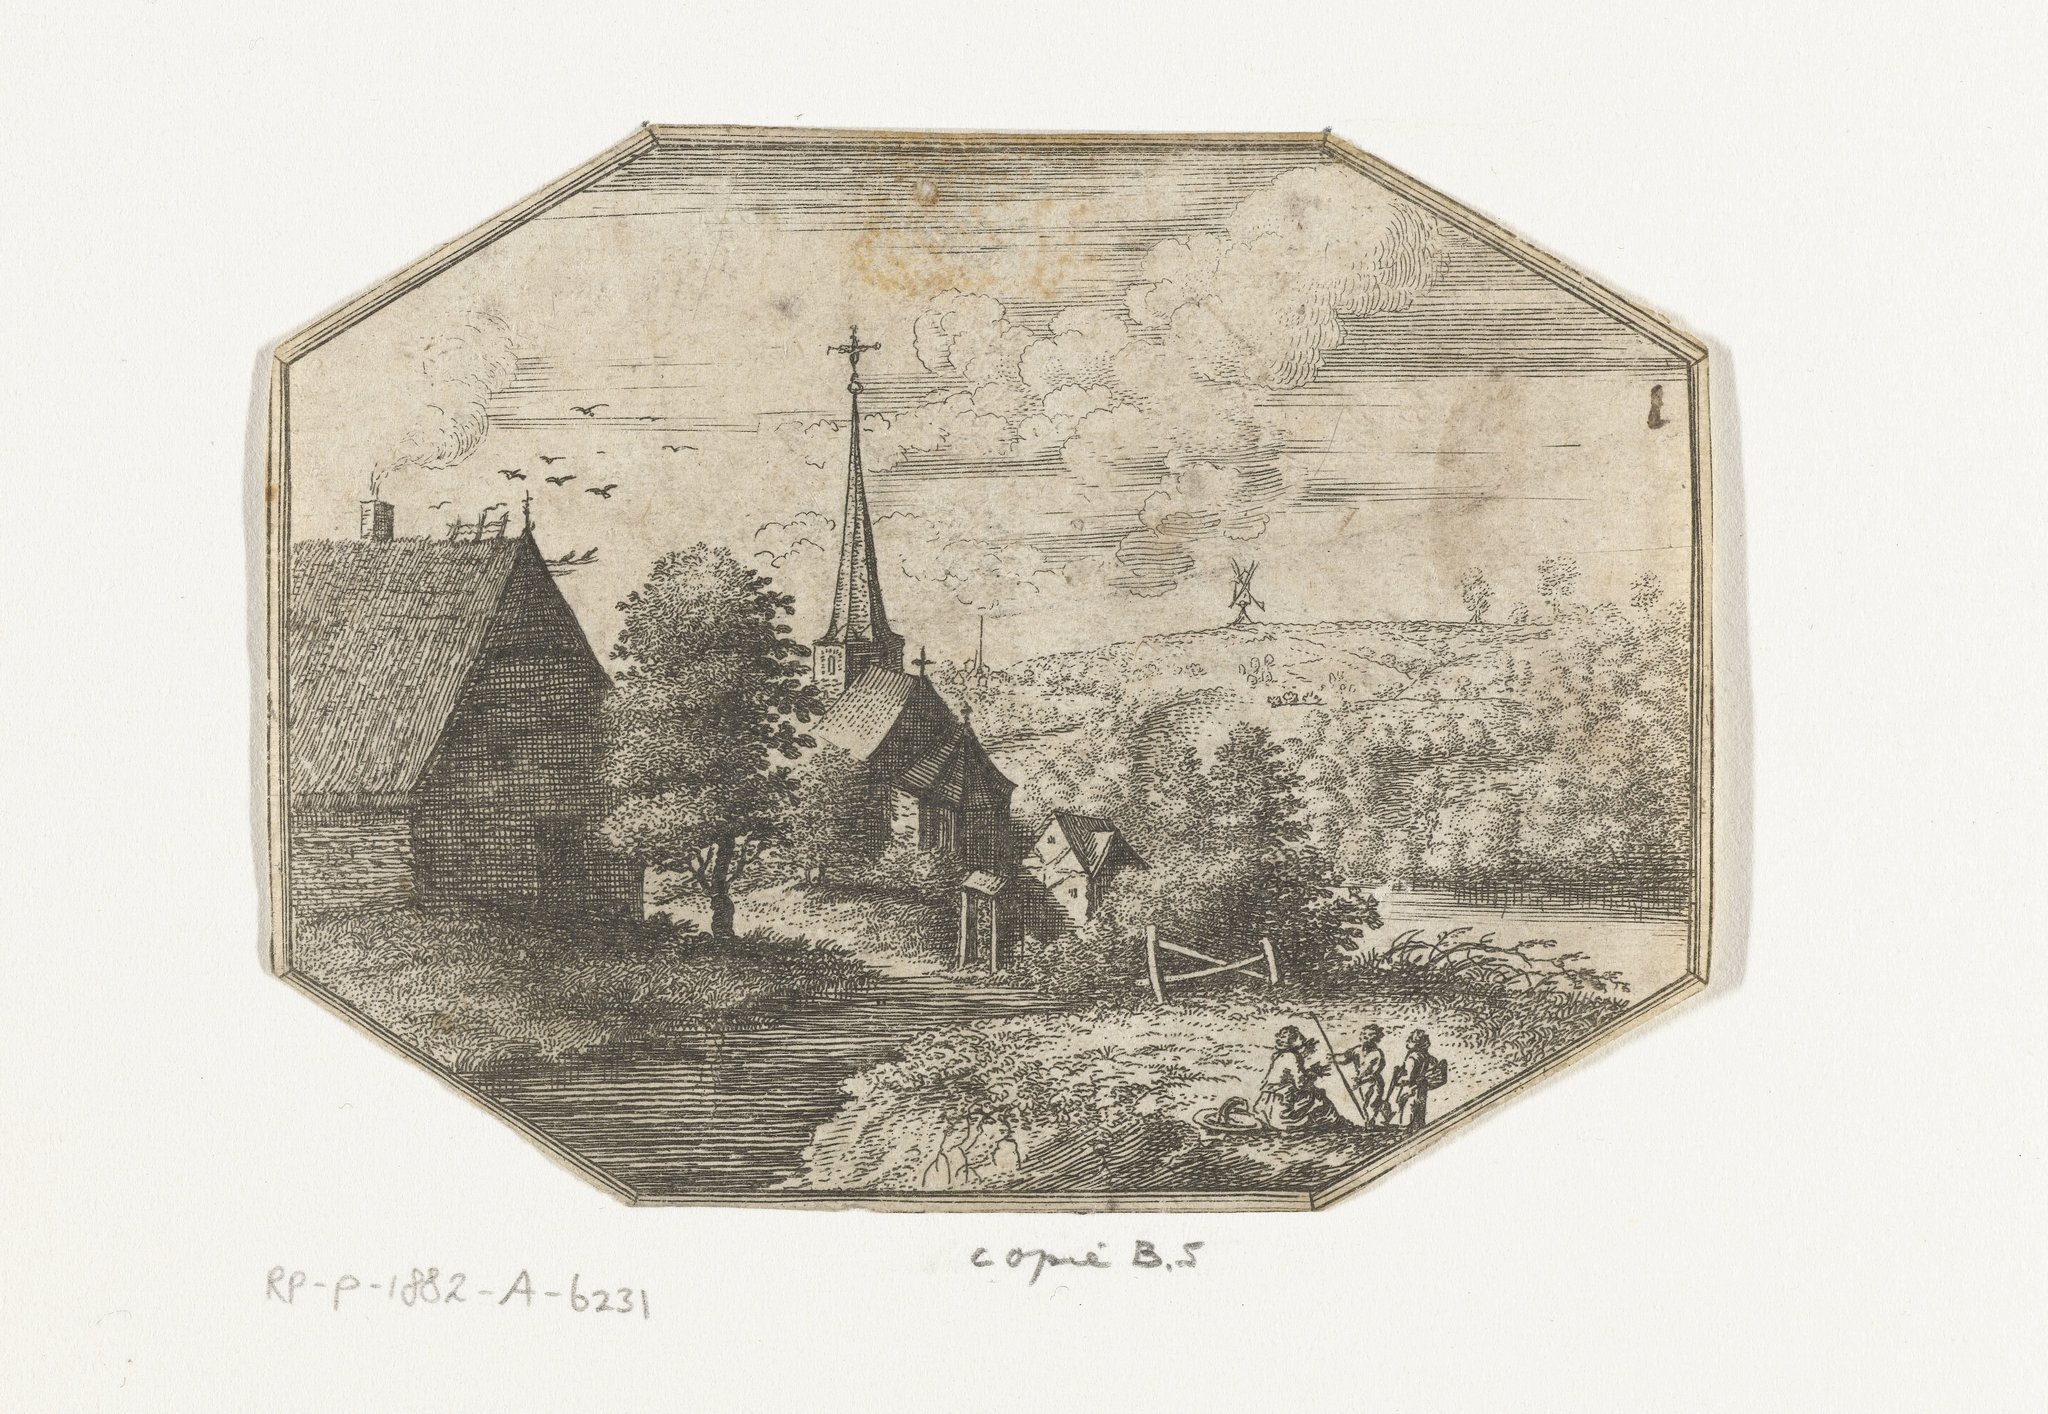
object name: print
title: Octagonale kopieën naar kleine landschappen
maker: Anonymous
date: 1605-1700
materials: paper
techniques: etching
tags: river, village, church (exterior)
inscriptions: number: ‘1’, collector's mark: Lugt 2228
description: Uit een serie van twaalf kopieën in spiegelbeeld. Landschap met een rivier stromend bij een klein dorp met een kerk.